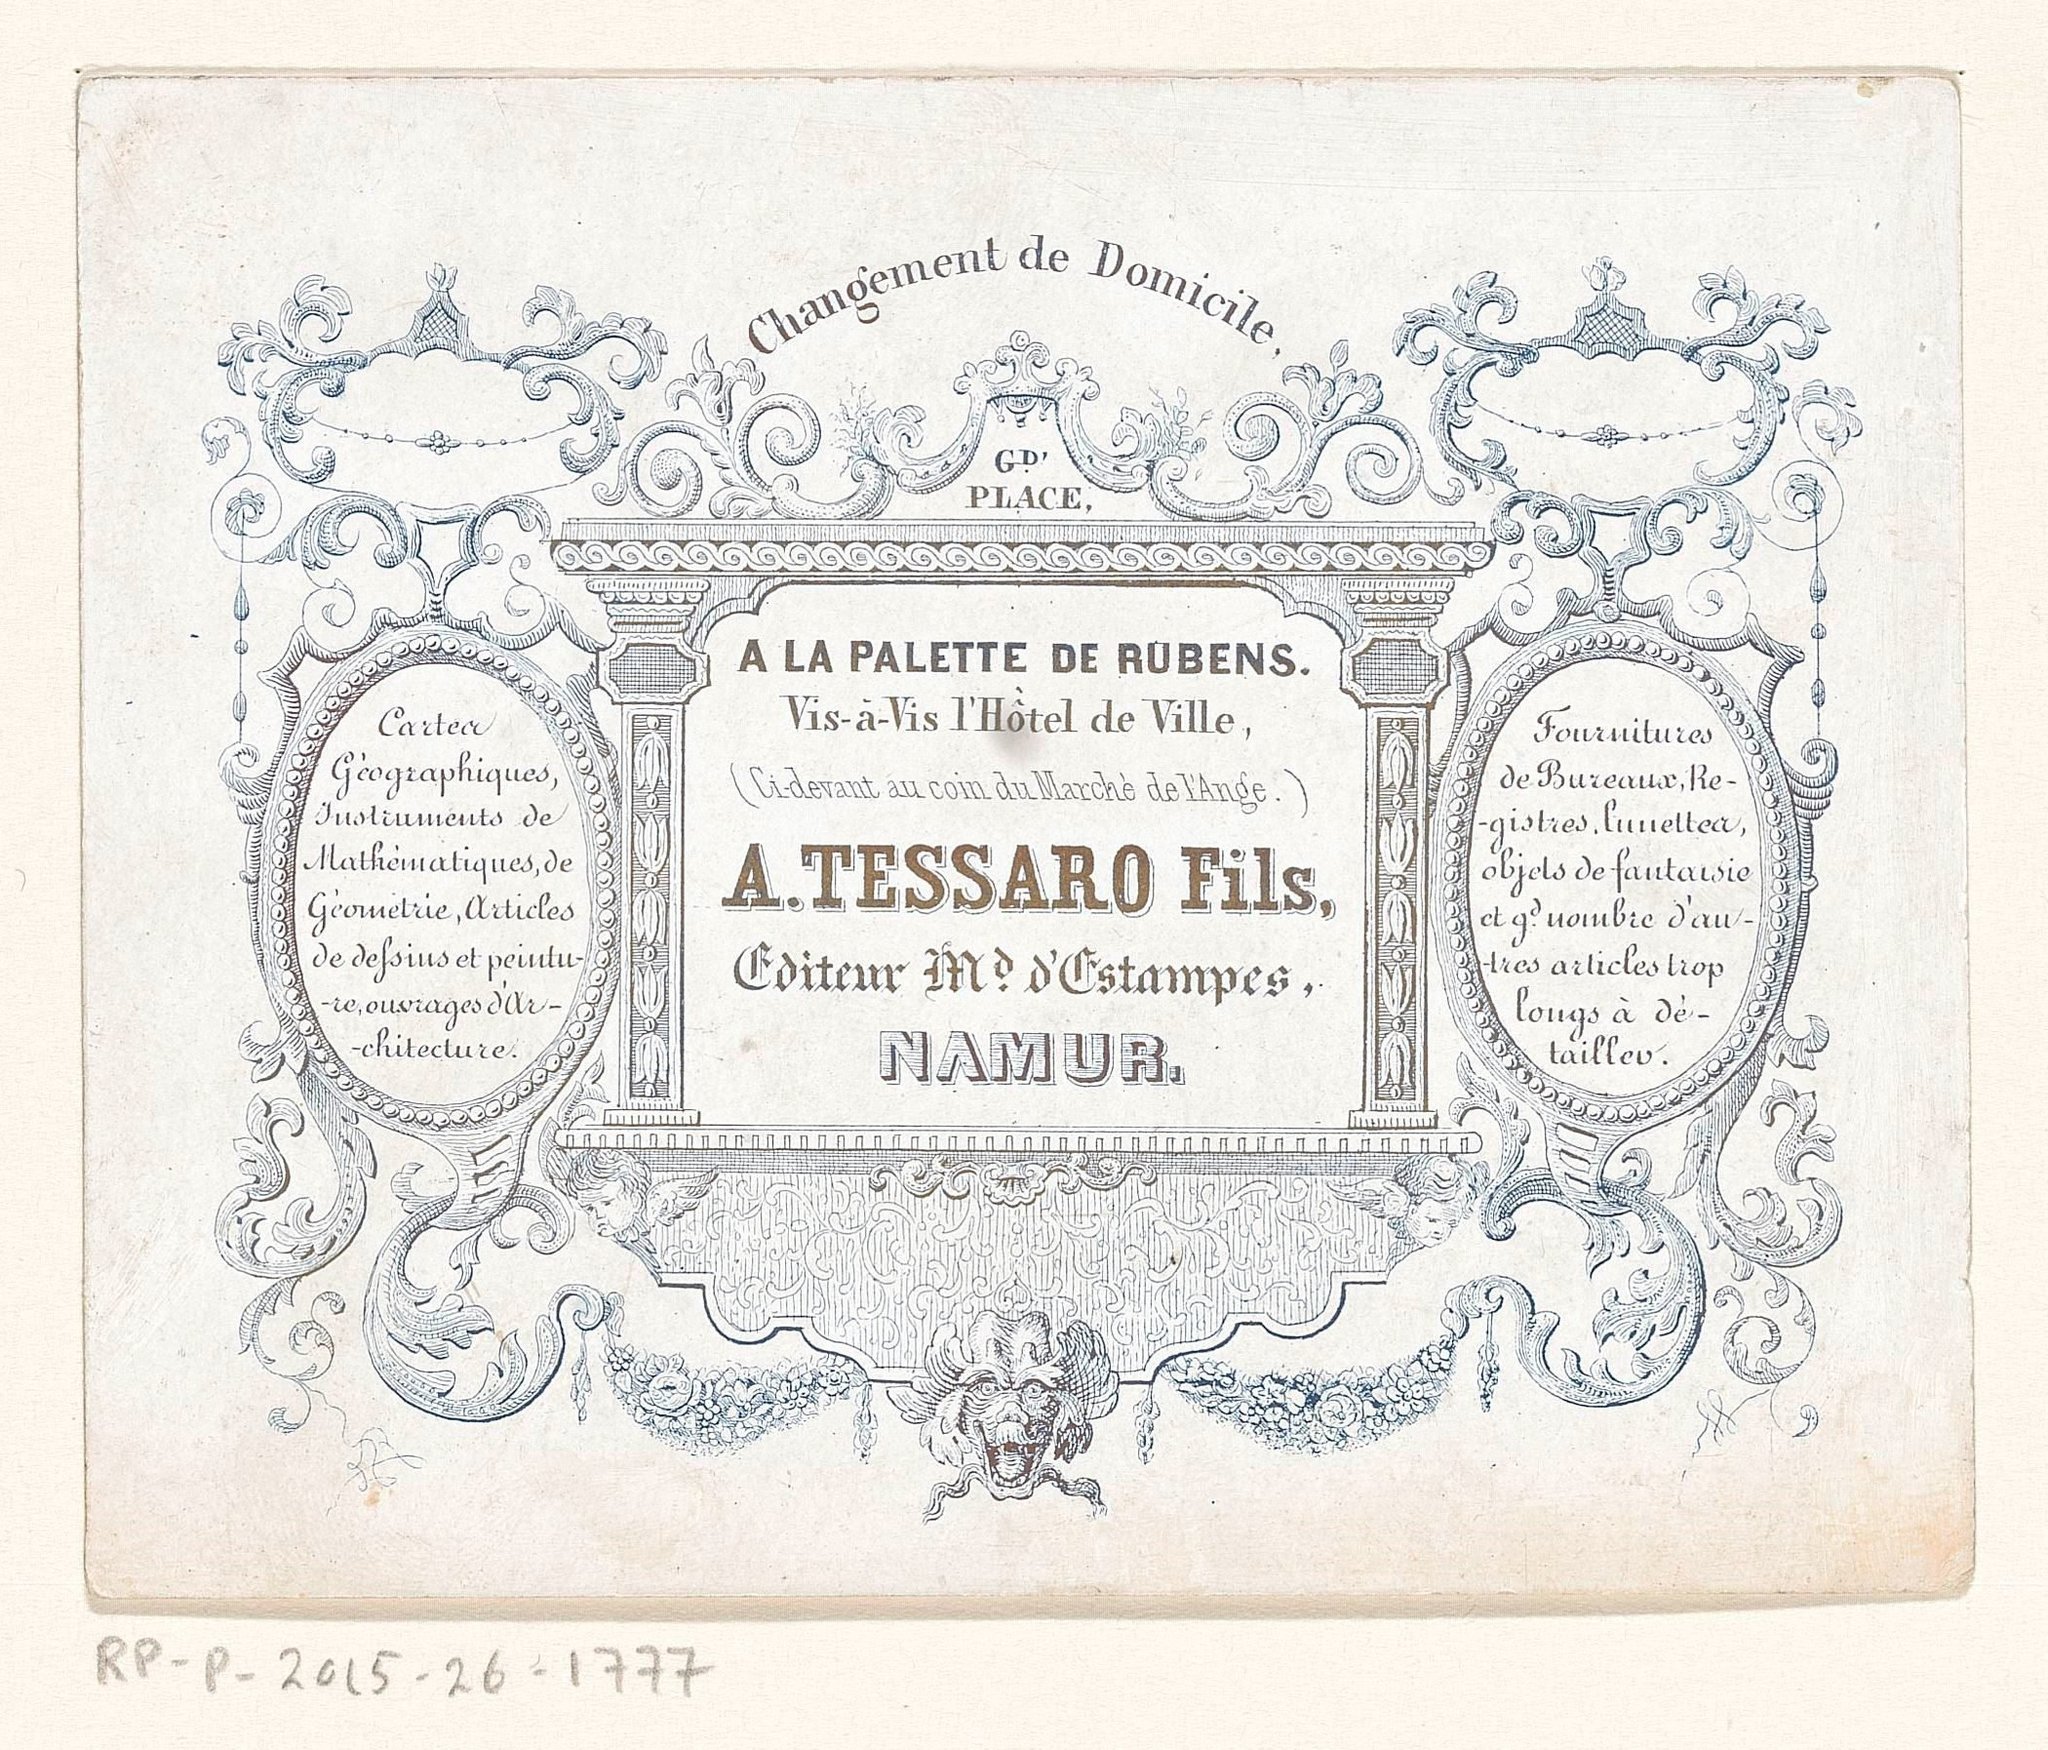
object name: porcelain card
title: Verhuiskaartje van prenthandelaar A. Tessaro fils te Namen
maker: Anonymous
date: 1840-1875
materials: porcelainized cardboard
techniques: lithograph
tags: namen (stad)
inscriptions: collector's mark: Lugt 2228